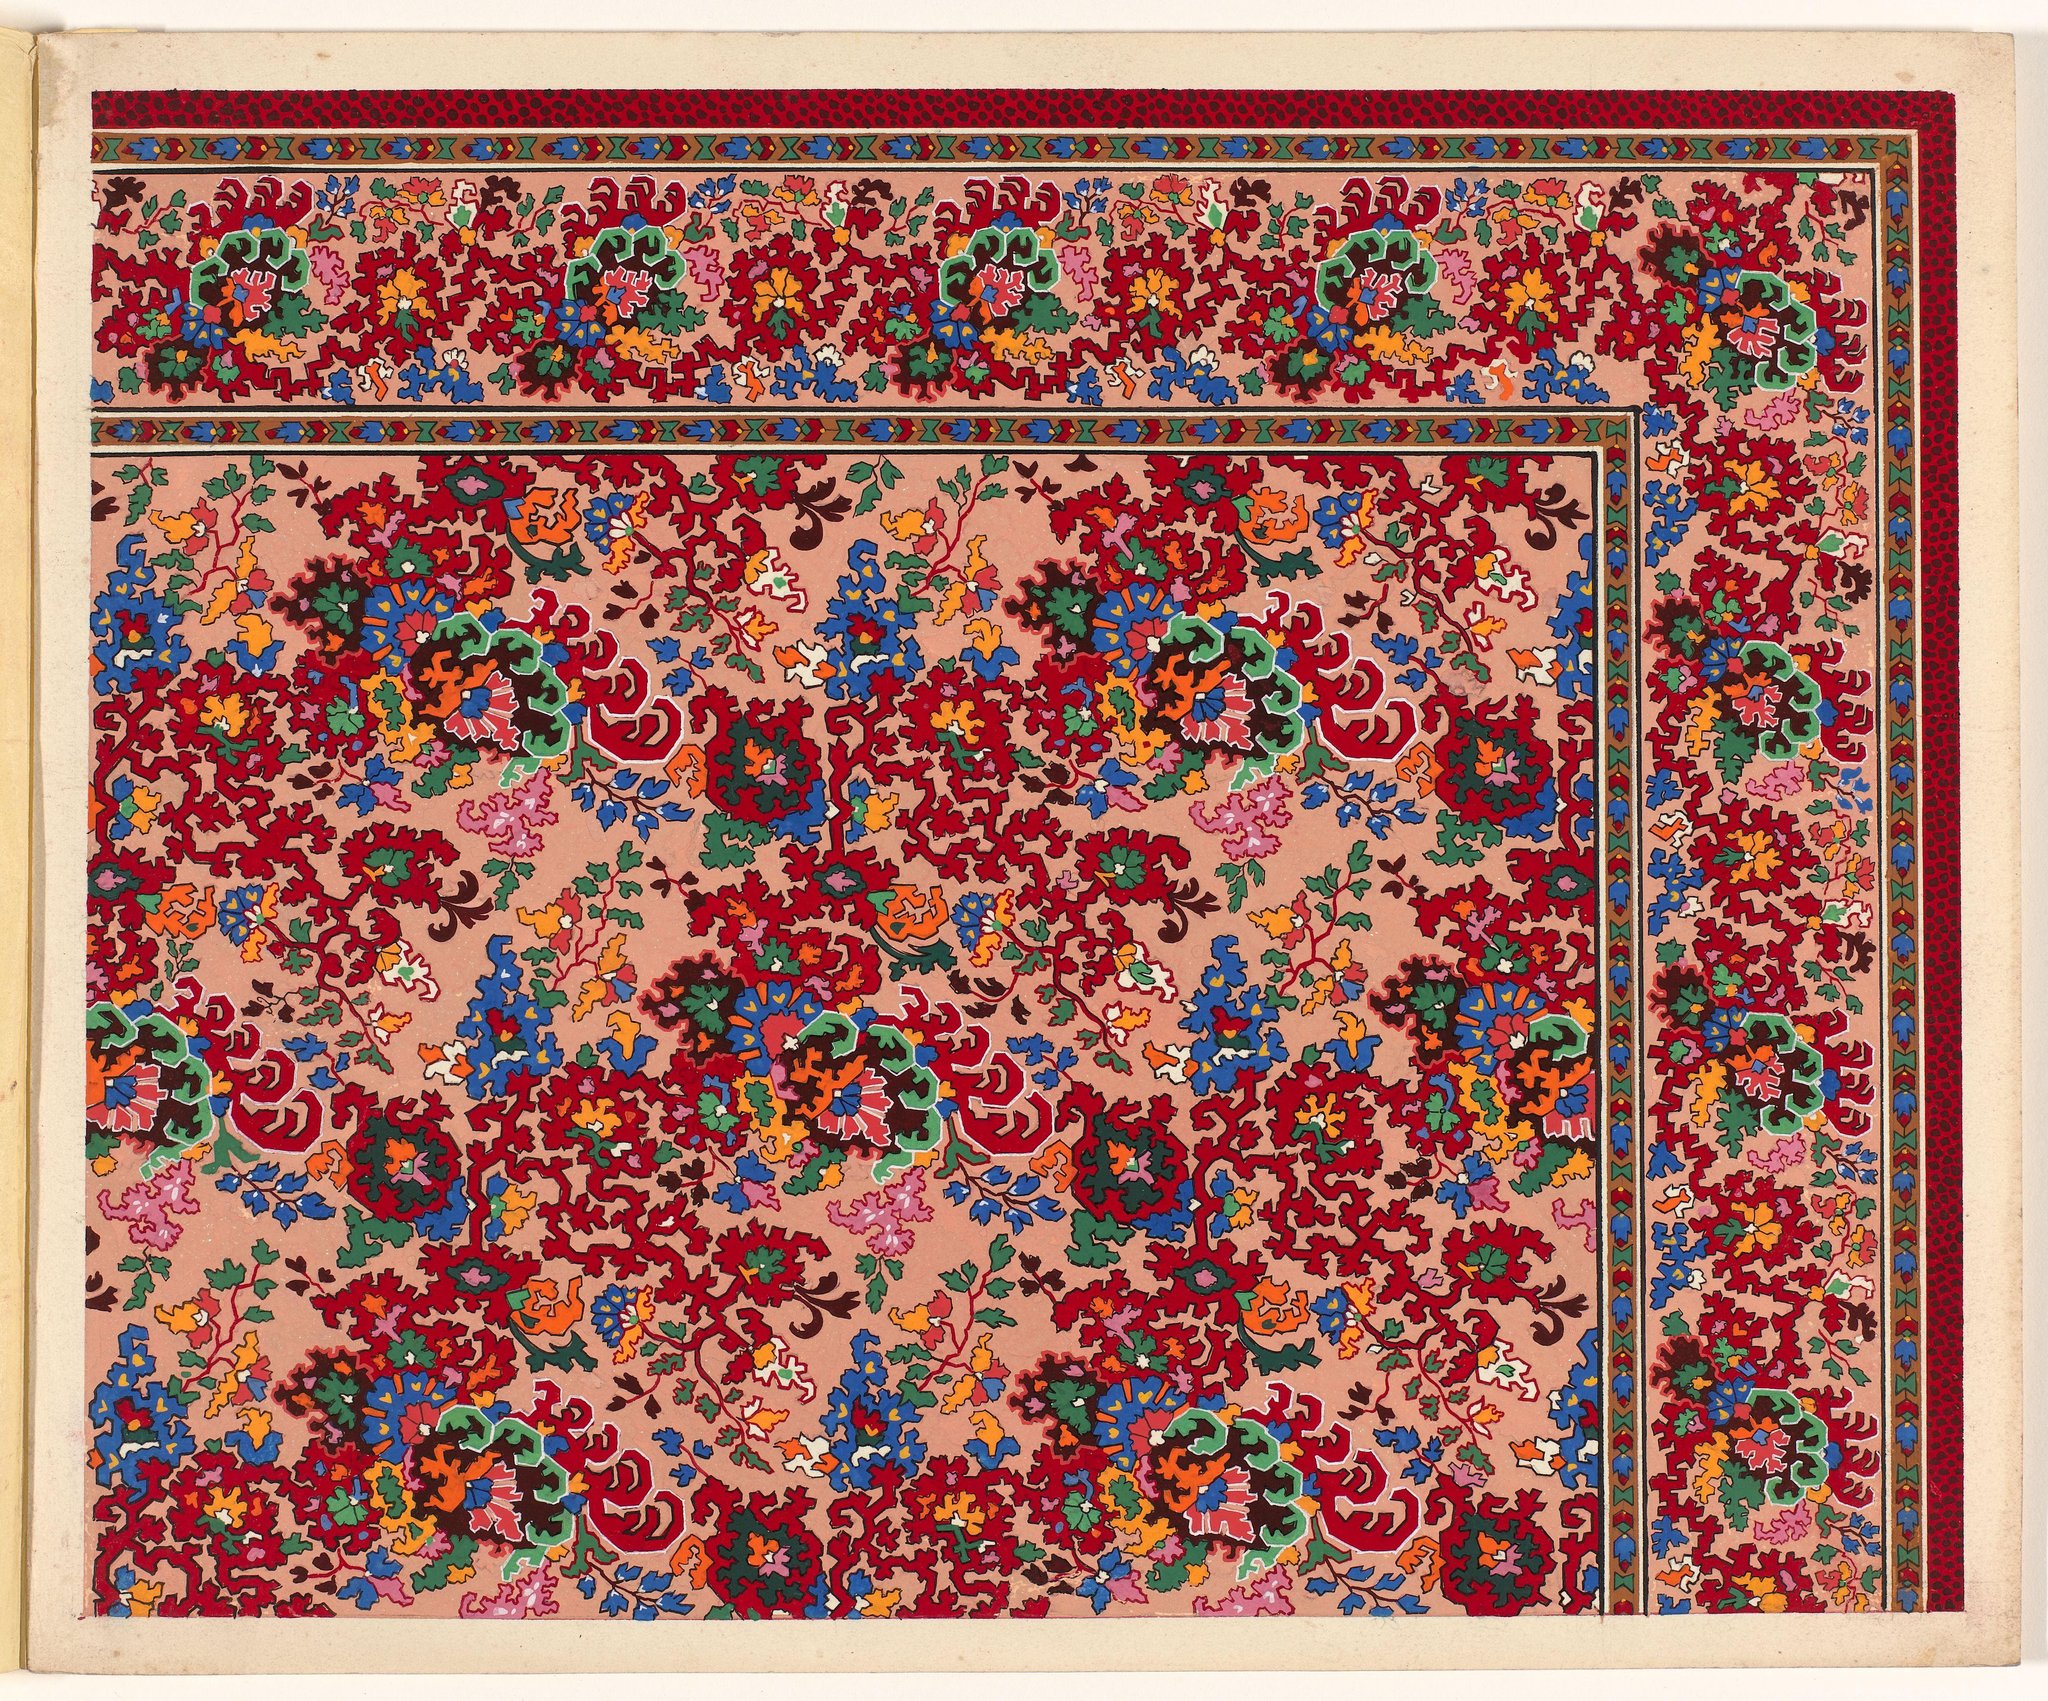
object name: drawing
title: Ontwerp voor een tapijt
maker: Anonymous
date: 1854-1864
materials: gouache, paper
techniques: brush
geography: deventer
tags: ornaments ~ art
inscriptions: number: ‘No 370.’, retailer's mark: ‘JHS.’, stamp: ‘Koninklyke Tapytfabriek Firma P. van Calcar & Co’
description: De presentatietekeningen BK-1971-77-1 t/m 86 zijn kopieën van de originele ontwerptekeningen. Ze werden gemaakt voor vertegenwoordigers van bijvoorbeeld magazijnen, die ze aan hun klanten konden tonen. De meeste tekeningen tonen een kwart van het dessin inclusief rand, middenpartij (de zogenaamde grond of fond) en centraal medaillon. Door het gebruik van spiegels kan de illusie van het gehele tapijt worden opgeroepen. Een deel van de tekeningen heeft een alfabetische opeenvolgende letter als kenmerk, de andere groep een cijfer.Waarschijnlijk is de reeks dessins met een letter eerder samengesteld dan de genummerde tekeningen.